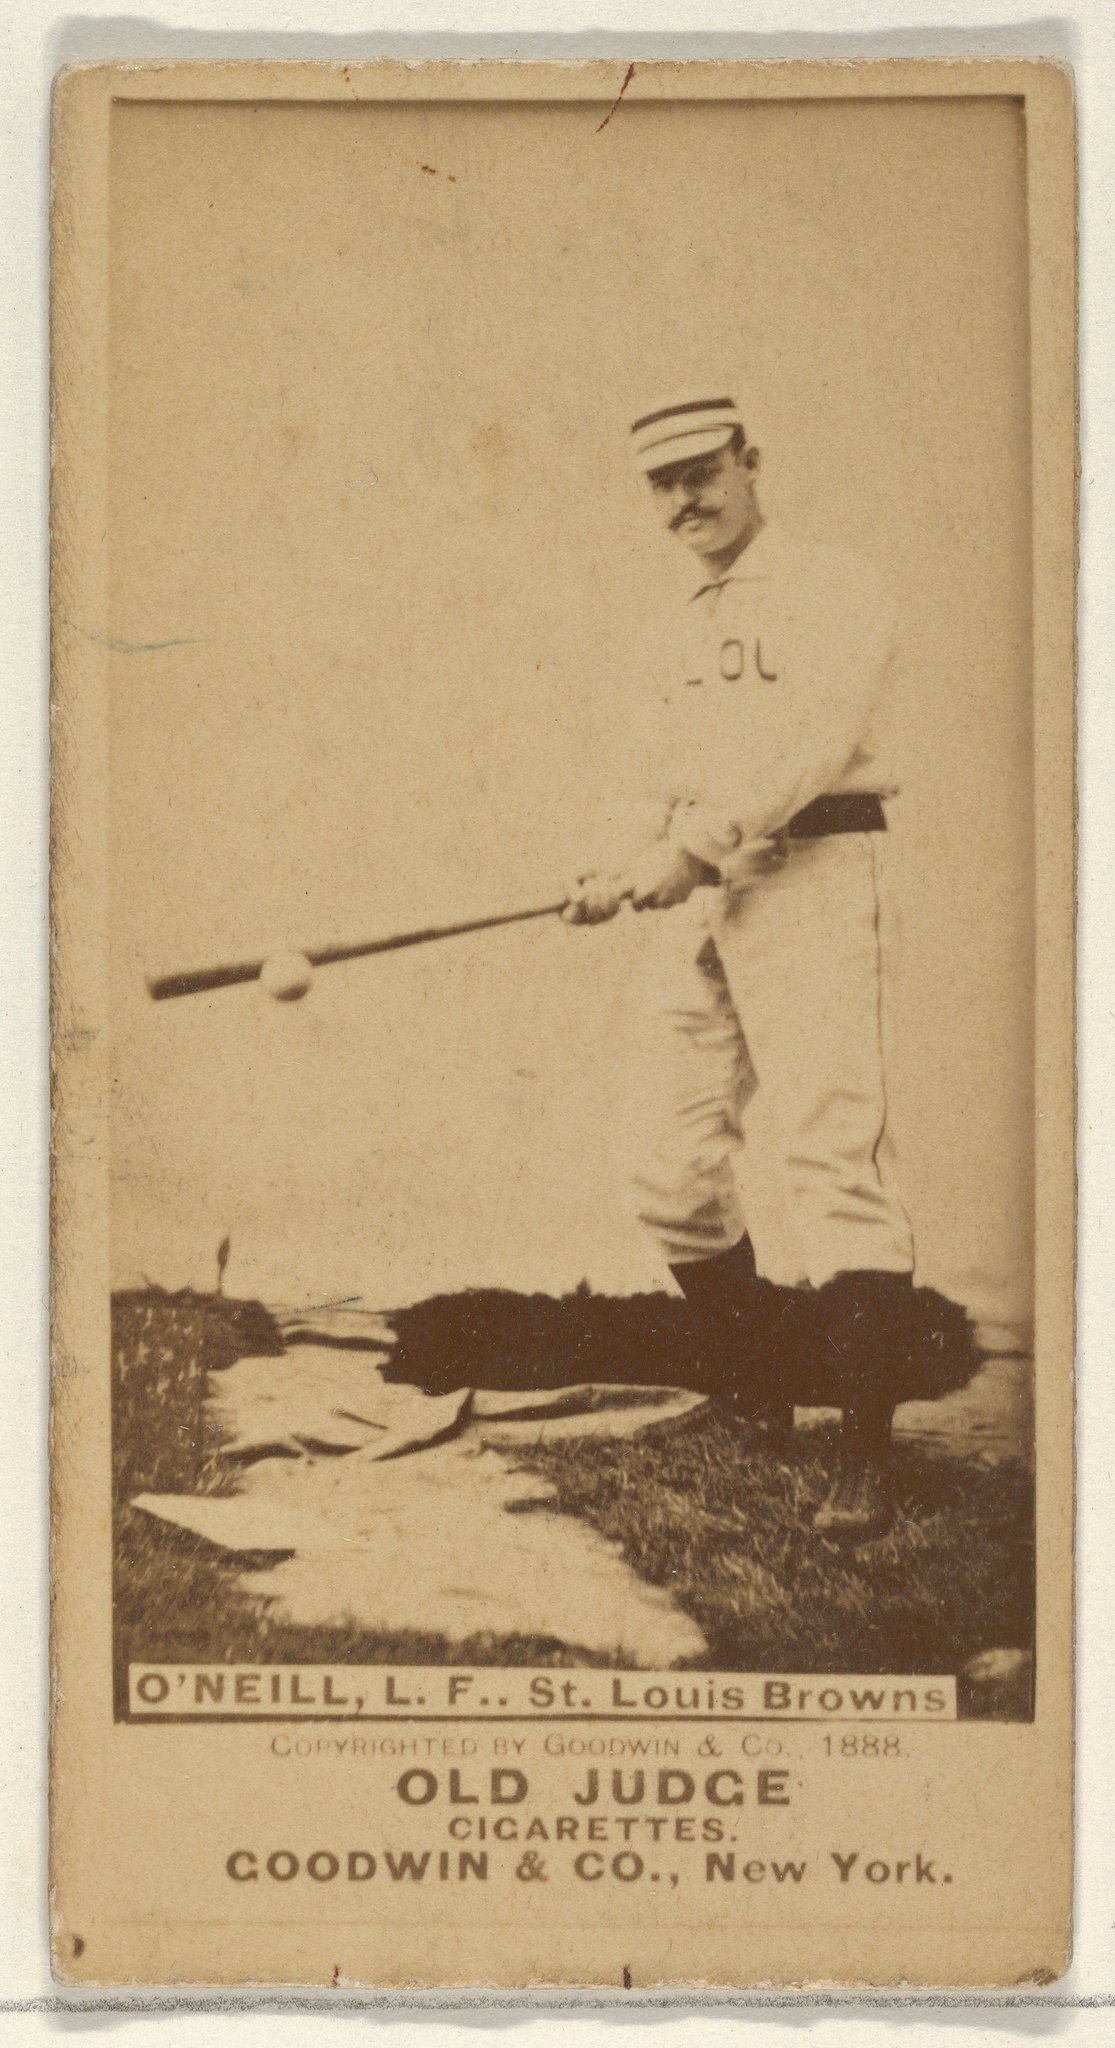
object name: baseball card, photograph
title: James Edward "Tip" O'Neill, Left Field, St. Louis Browns, from the Old Judge series (N172) for Old Judge Cigarettes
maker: goodwin & company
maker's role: publisher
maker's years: 1850-1950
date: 1888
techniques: albumen silver print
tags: men,portraits,baseball,athletes